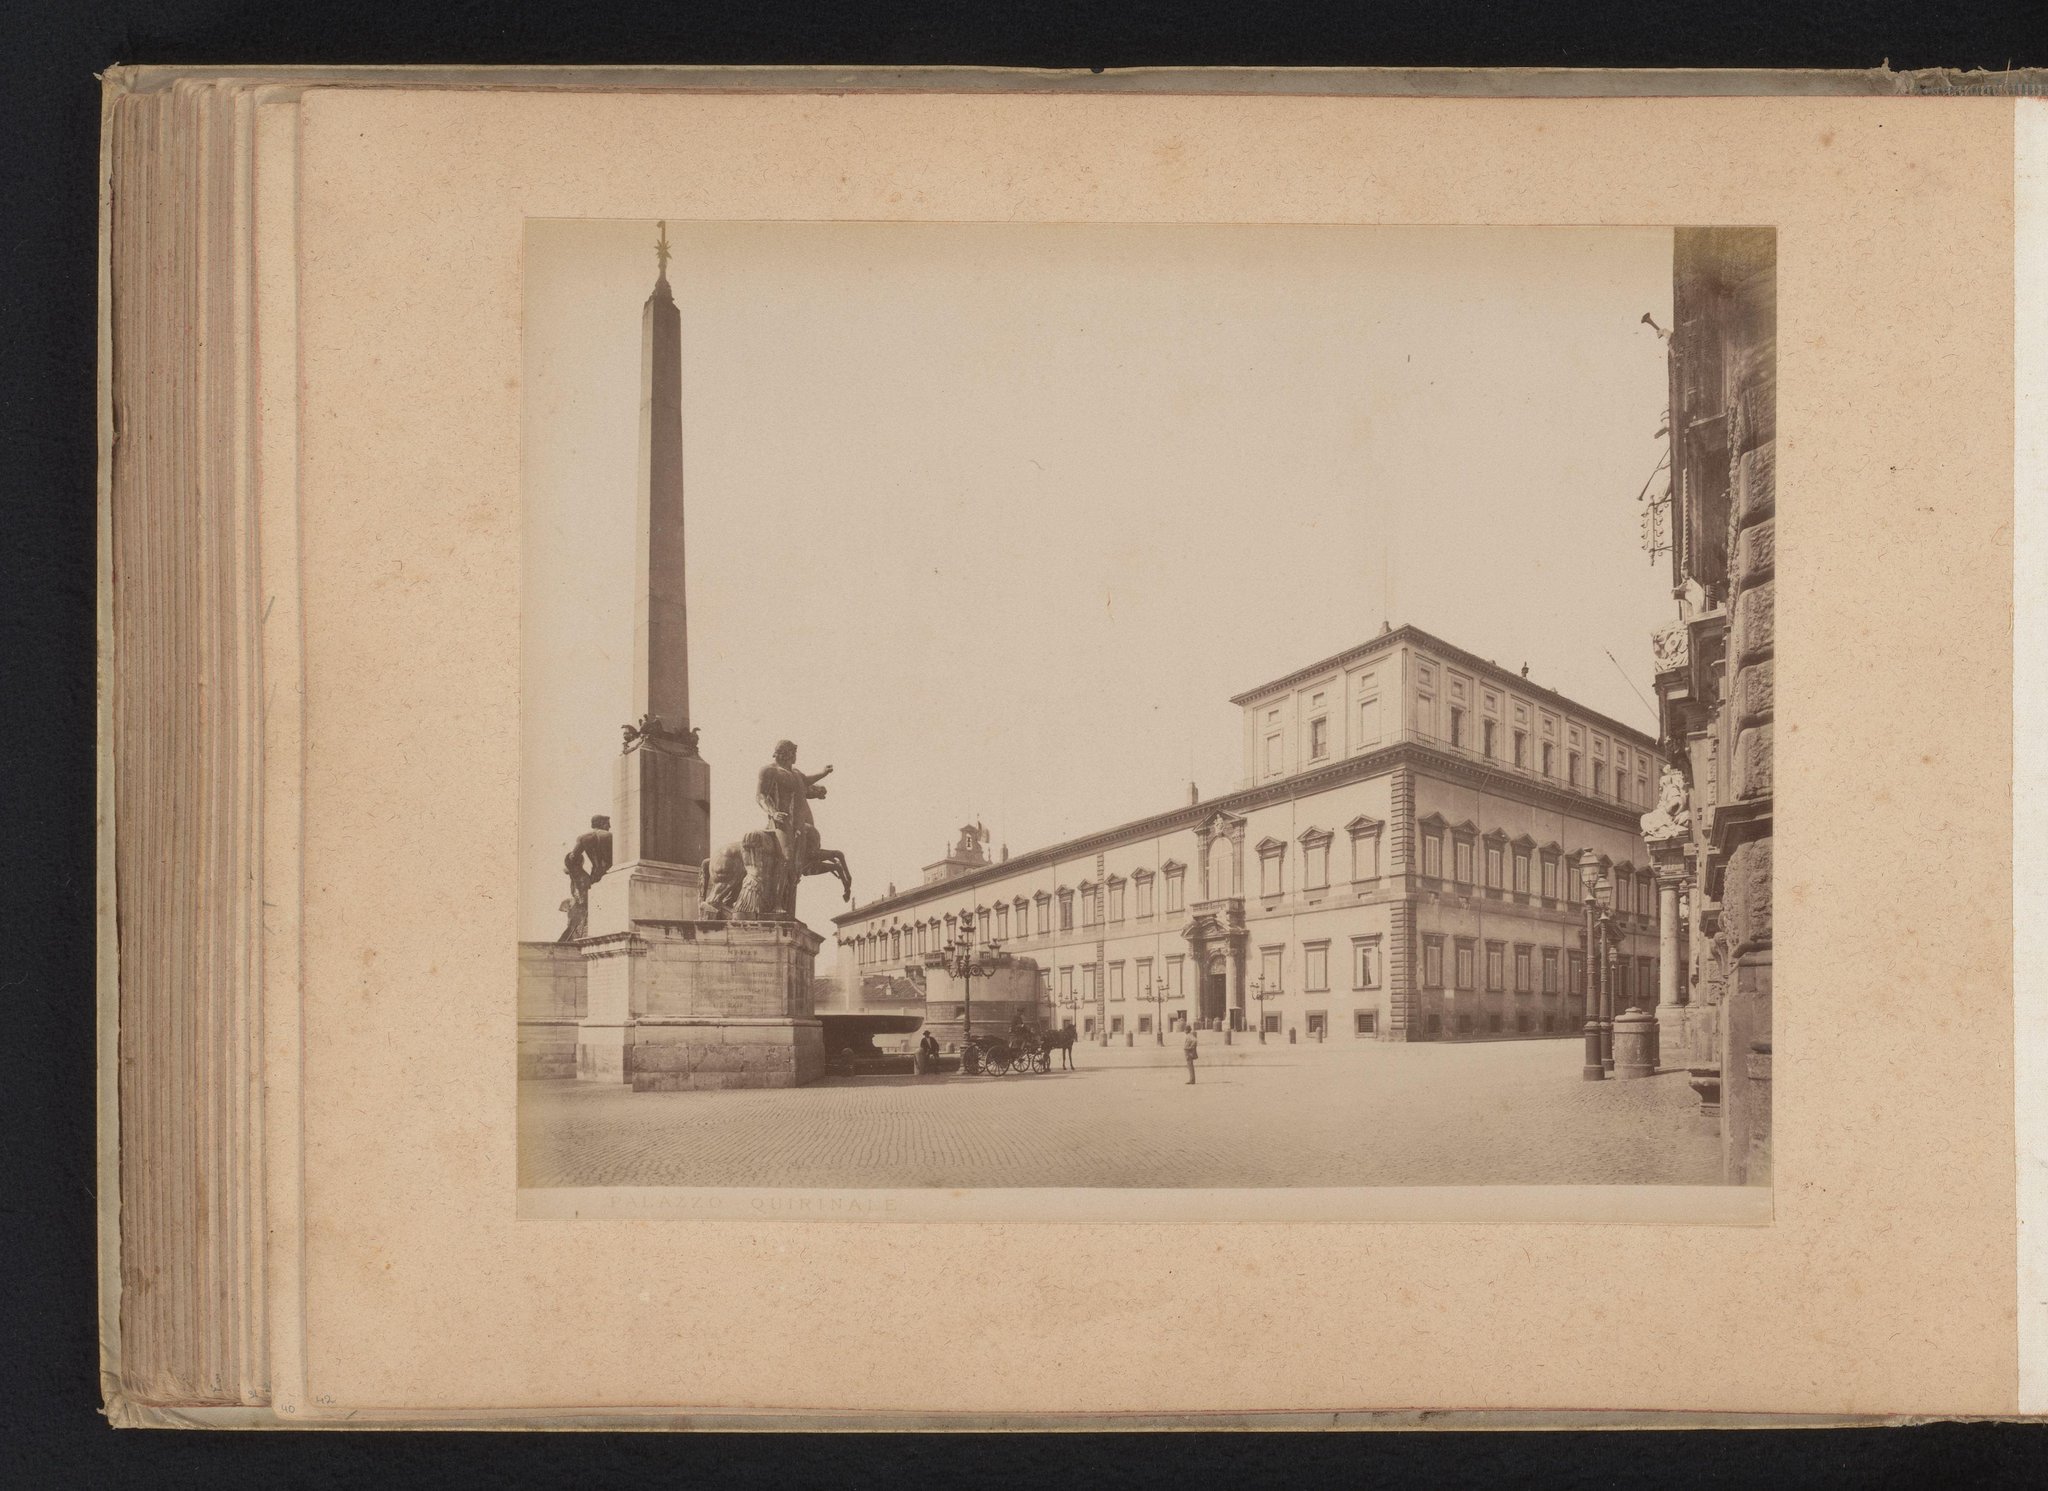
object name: photograph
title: Gezicht op het Palazzo del Quirinale in Rome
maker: Anonymous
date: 1870-1895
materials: cardboard, photographic support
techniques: albumen print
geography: rome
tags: palace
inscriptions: inscription: ‘8[.]2 PALAZZO QUIRINALE’